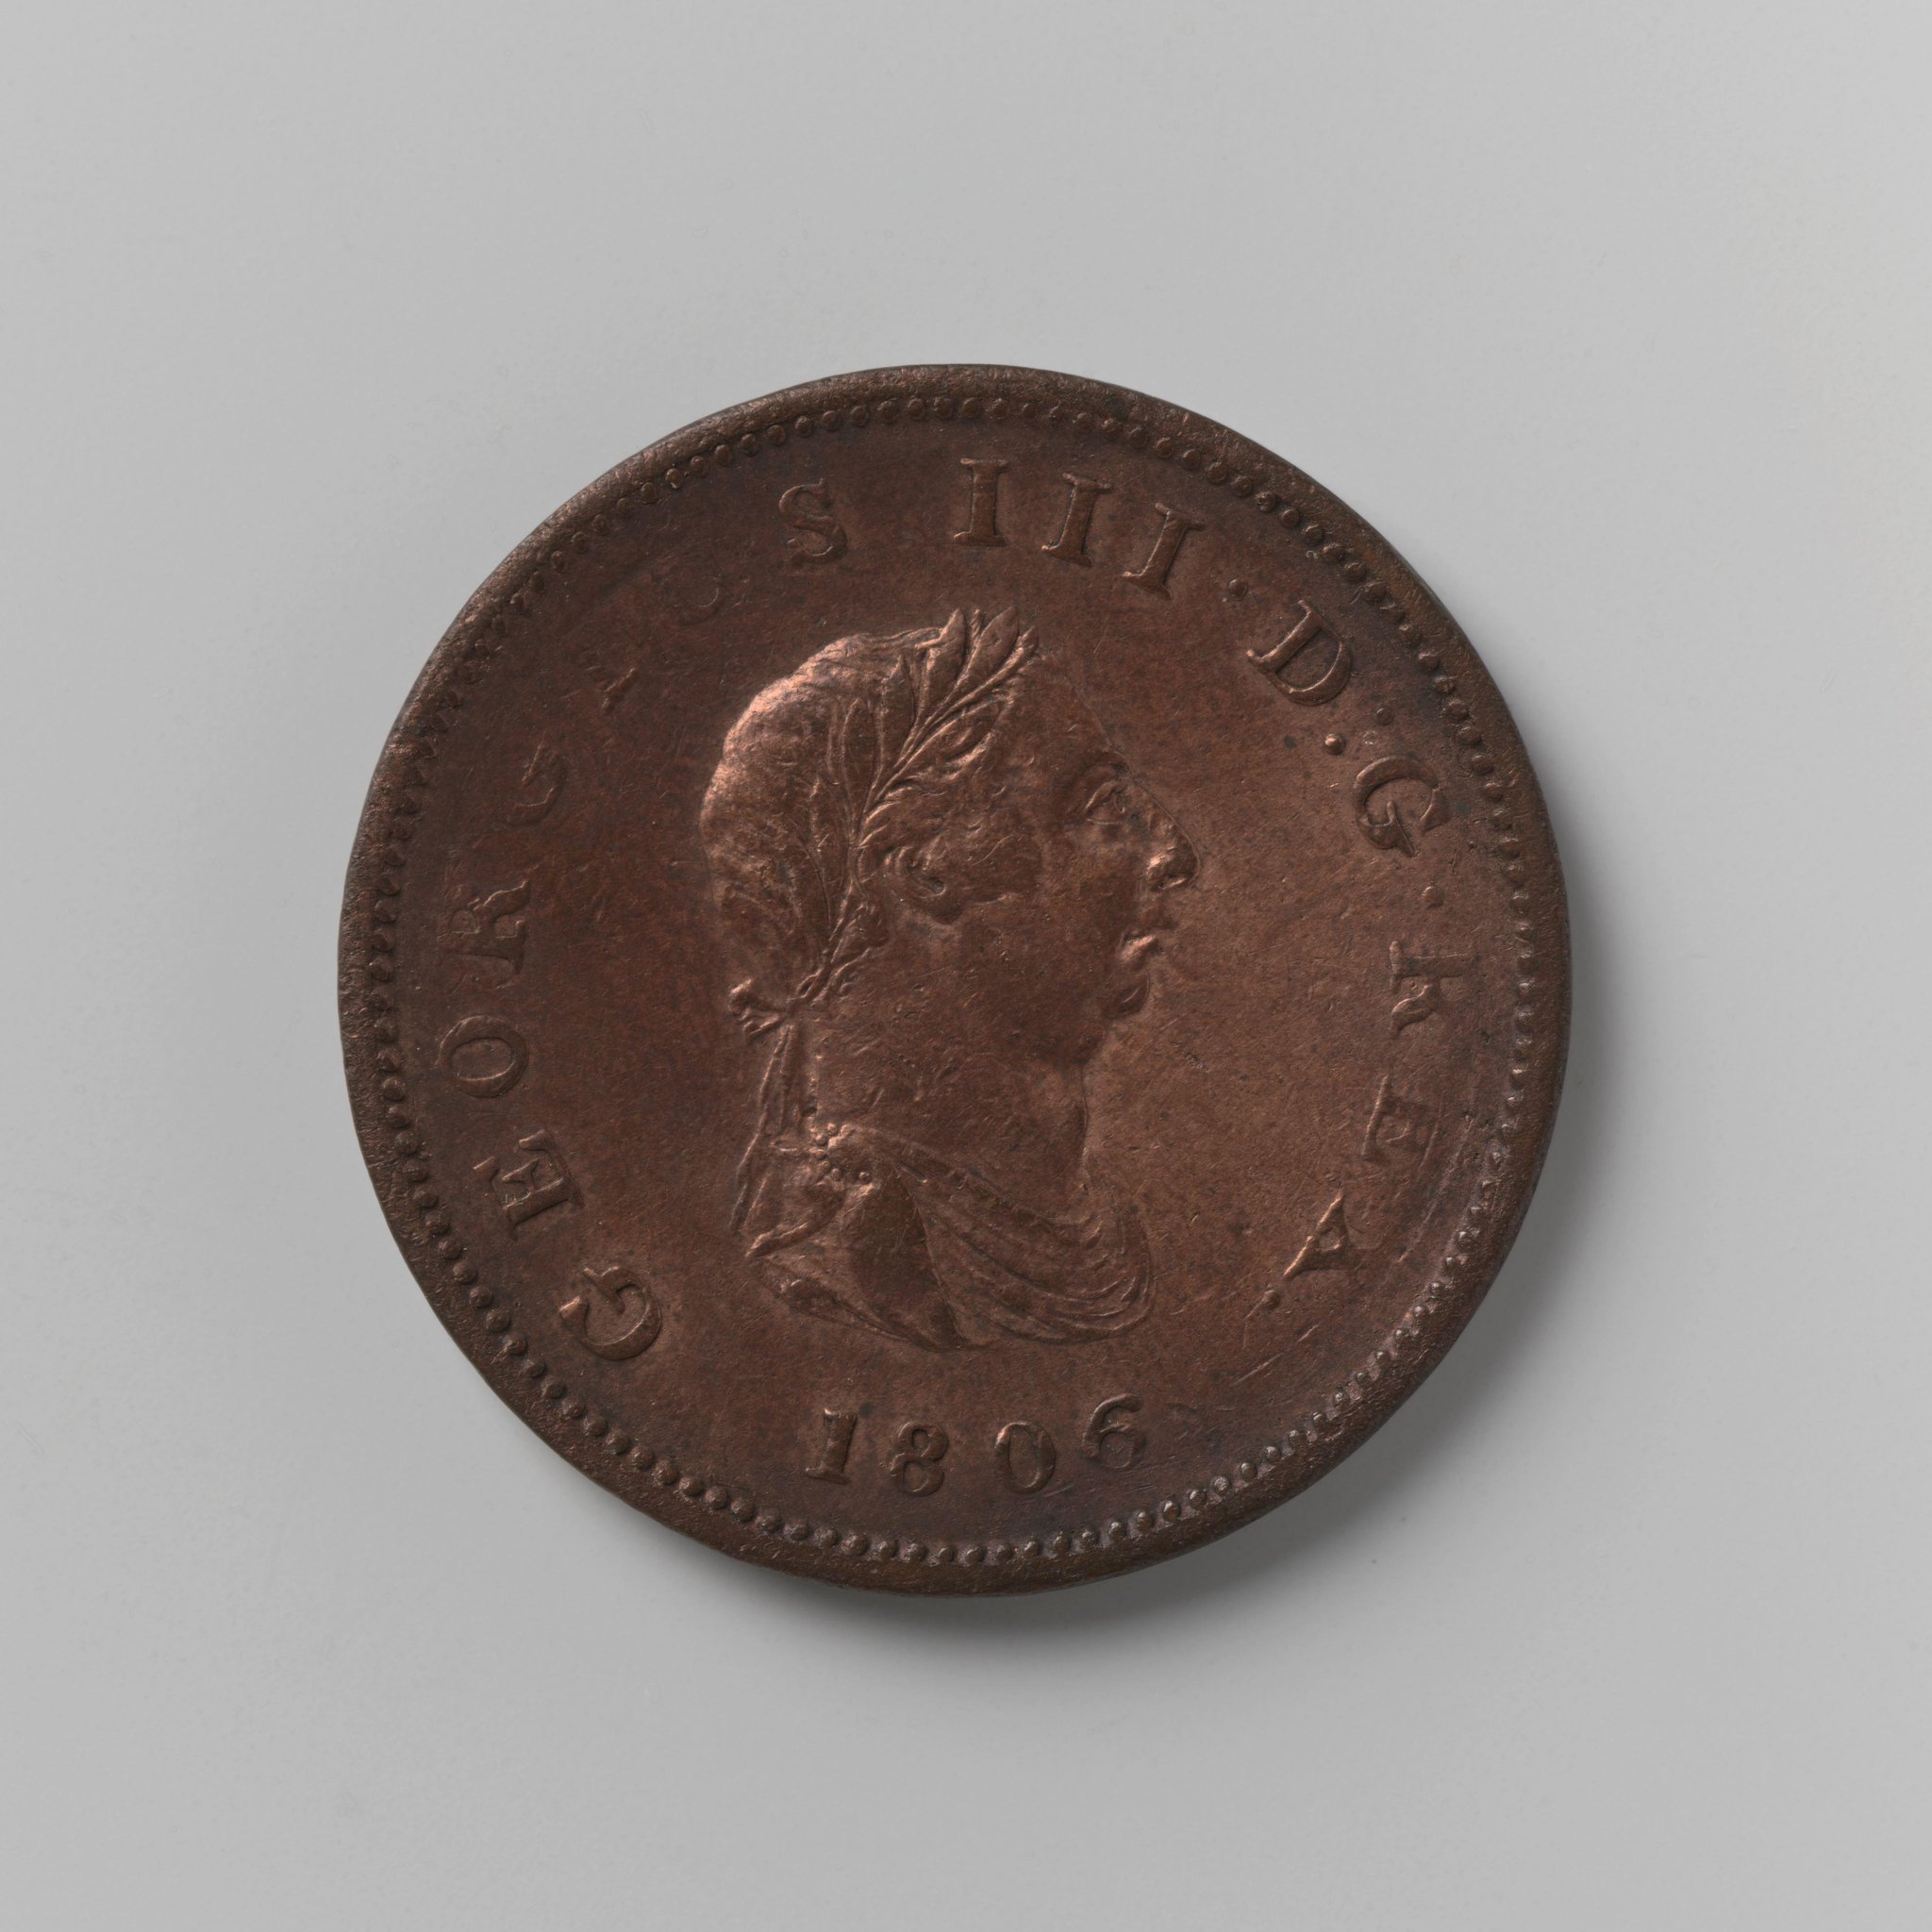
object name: coin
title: ½ penny uit Engeland van George III, 1806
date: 1806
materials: copper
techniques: striking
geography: birmingham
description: Koperen munt. Voorzijde: gelauwerd borstbeeld van de koning naar rechts. Jaartal in omschrift onderaan. Keerzijde: op uit zee opstijgende rots, waartegen schild geplaatst, gezeten Brittannia met drietand en tak, naar links. Links van haar schip. Kartelrand.